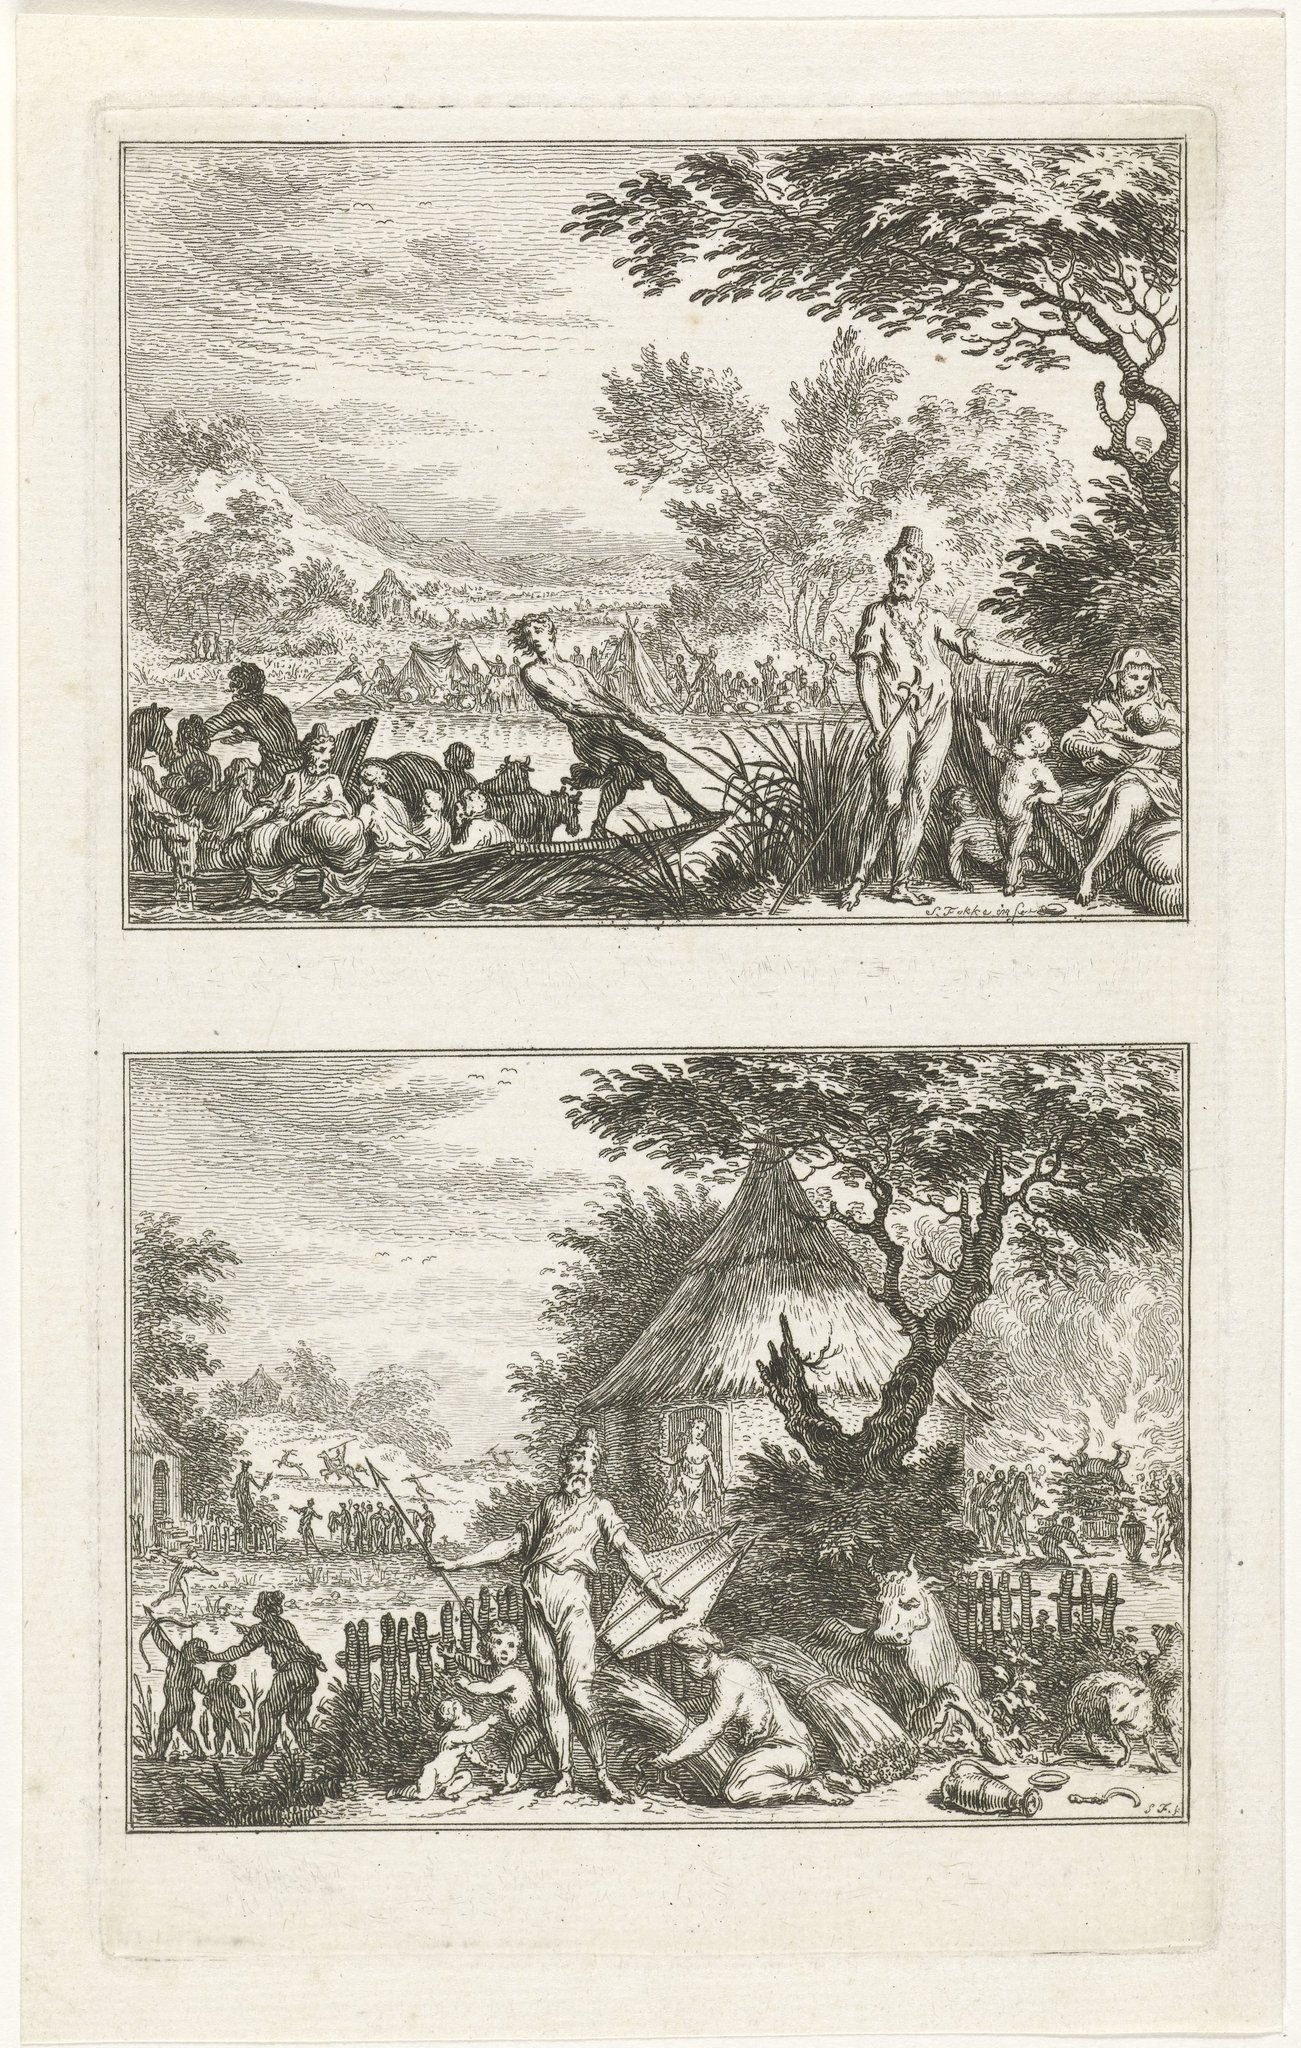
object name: print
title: Bataven vervoerd per boot / Bataafse nederzetting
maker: simon fokke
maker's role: draughtsman, print maker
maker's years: 1712-1784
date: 1722-1784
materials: paper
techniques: etching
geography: amsterdam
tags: poling, punting, founding a village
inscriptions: collector's mark: Lugt 2228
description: Voorstellingen uit de vaderlandse geschiedenis. Boven: Een groep Bataven wordt met hun bezittingen per boot vervoerd. Op de oever staat naast een vrouw met drie kinderen een man met een speer in zijn hand. Onder: Een Bataafse nederzetting met op de voorgrond een man met speer en schild omringd door twee kinderen, een vrouw en dieren.